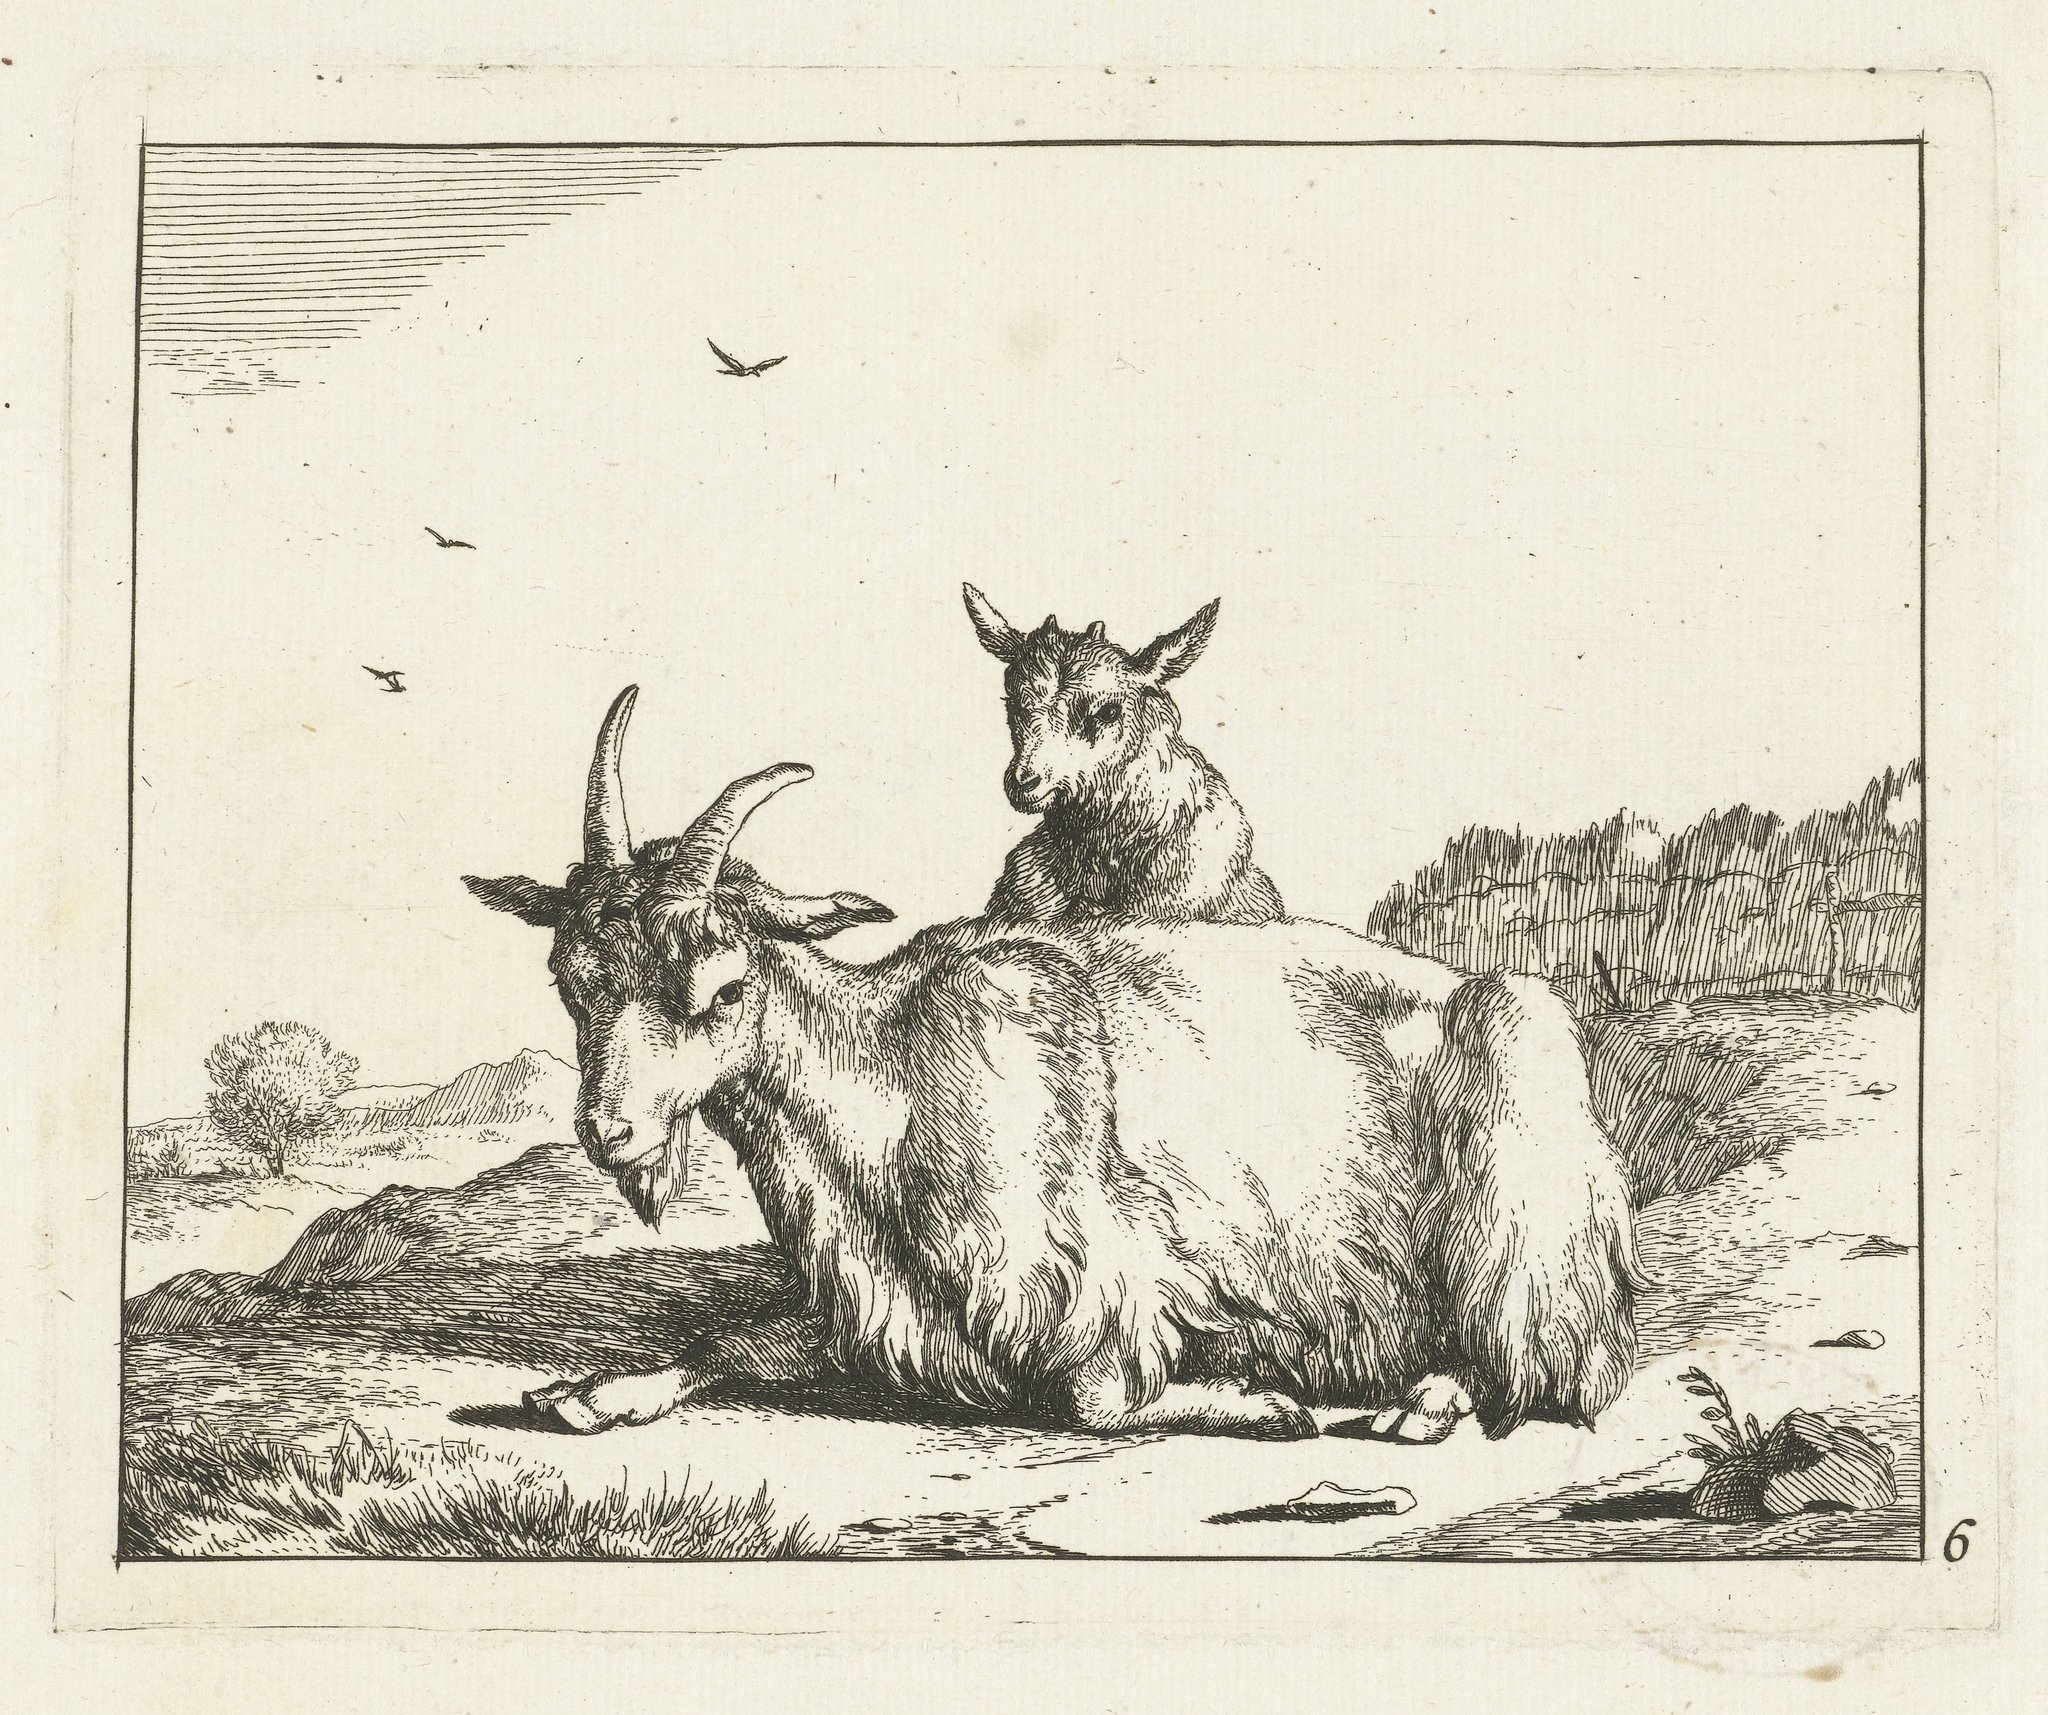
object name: print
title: Geiten en bokken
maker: marcus de bye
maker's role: print maker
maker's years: 1639-1688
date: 1657-1677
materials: paper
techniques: etching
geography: the hague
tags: goat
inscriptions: collector's mark: Lugt 240